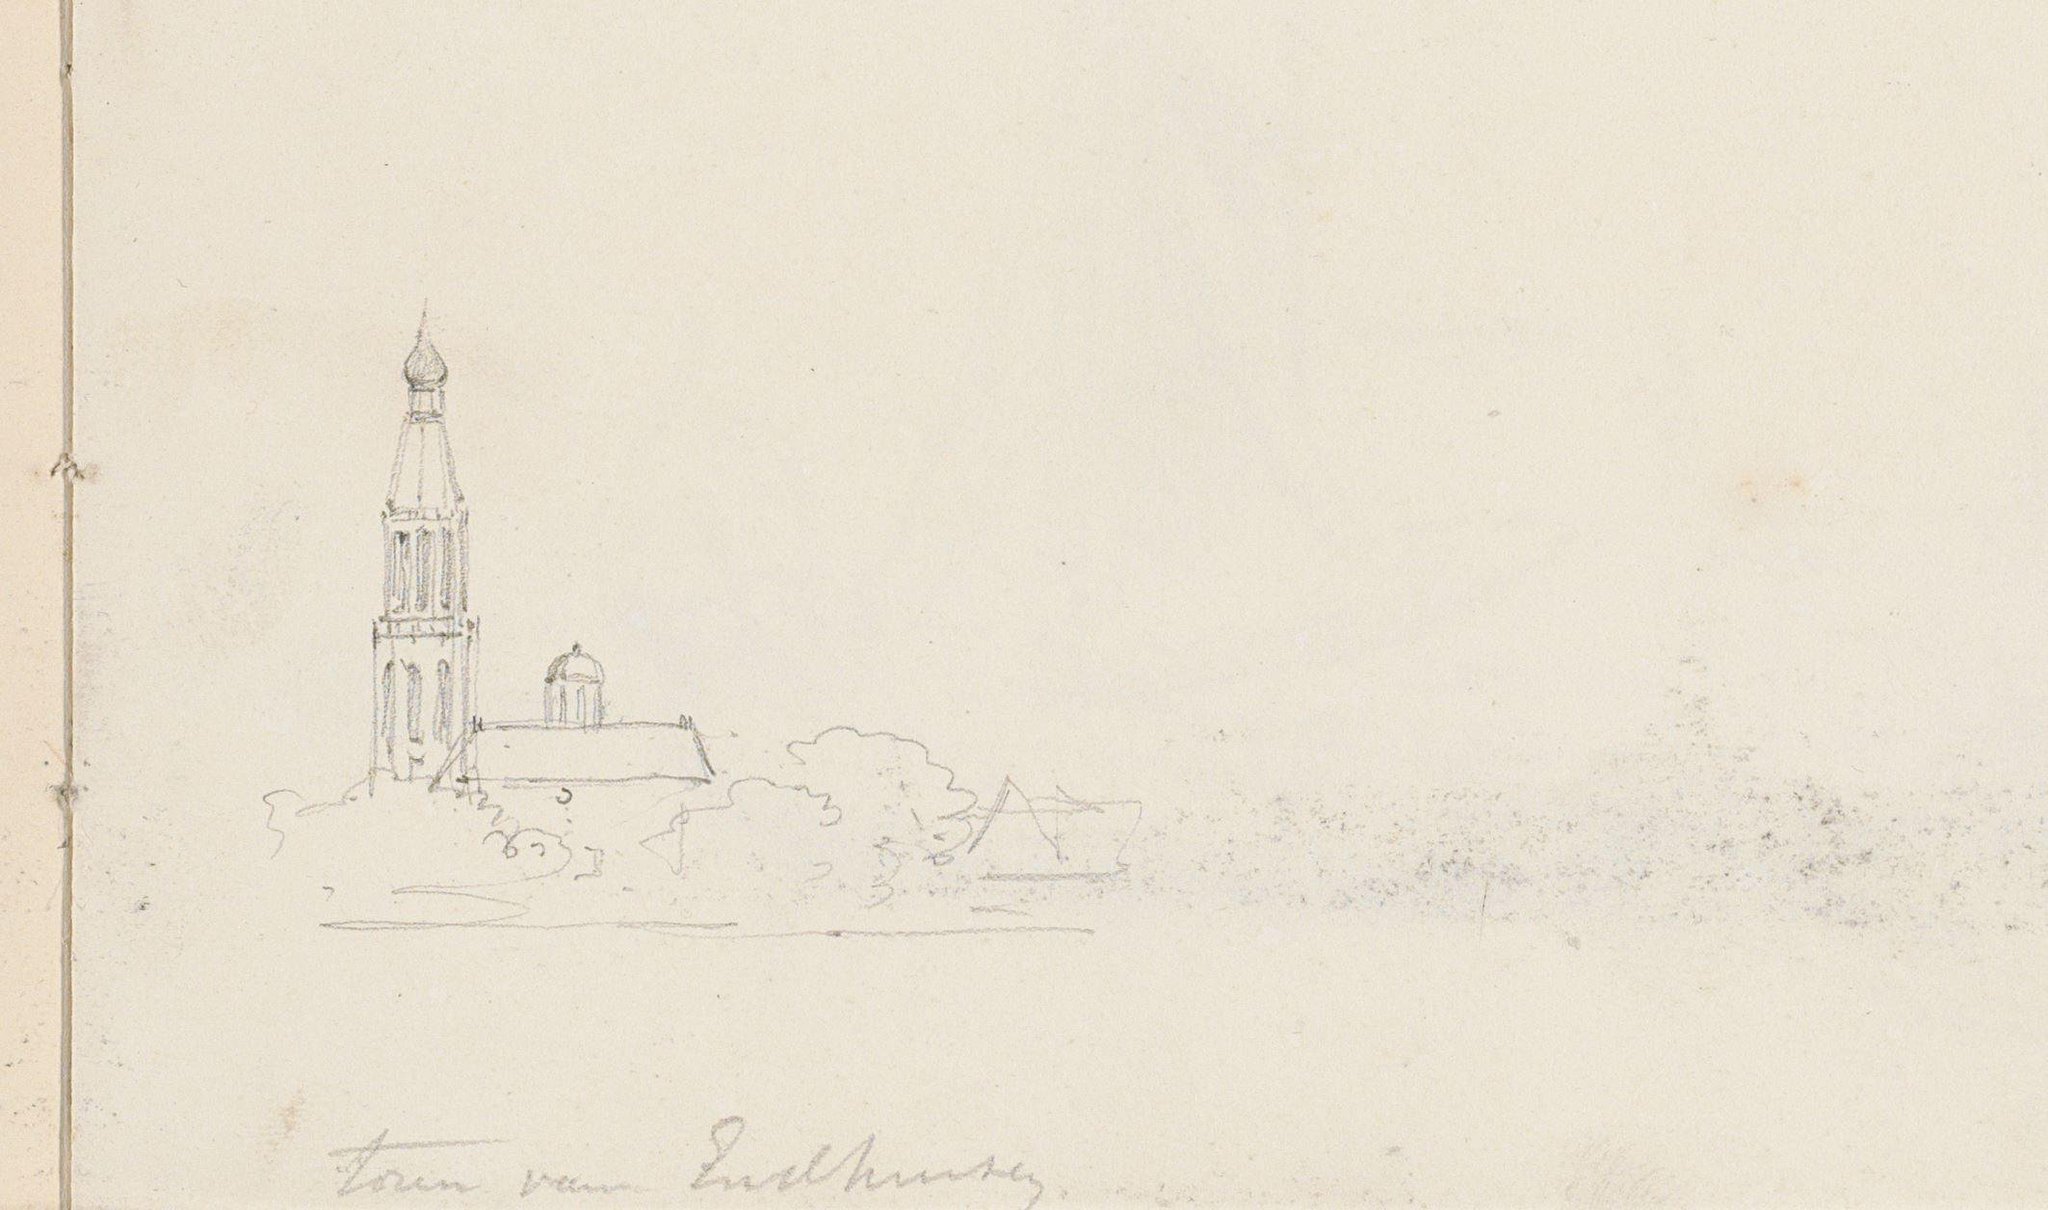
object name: sketchbook leaf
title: Toren van de Zuiderkerk te Enkhuizen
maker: petrus johannes schotel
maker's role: draughtsman, painter, print maker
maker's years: 1808-1865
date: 1841-1865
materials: paper, pencil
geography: enkhuizen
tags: parts of church exterior and annexes: tower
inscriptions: annotation: ‘toren van Enkhuizen.’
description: Pagina 37 uit een schetsboek met 80 pagina's.